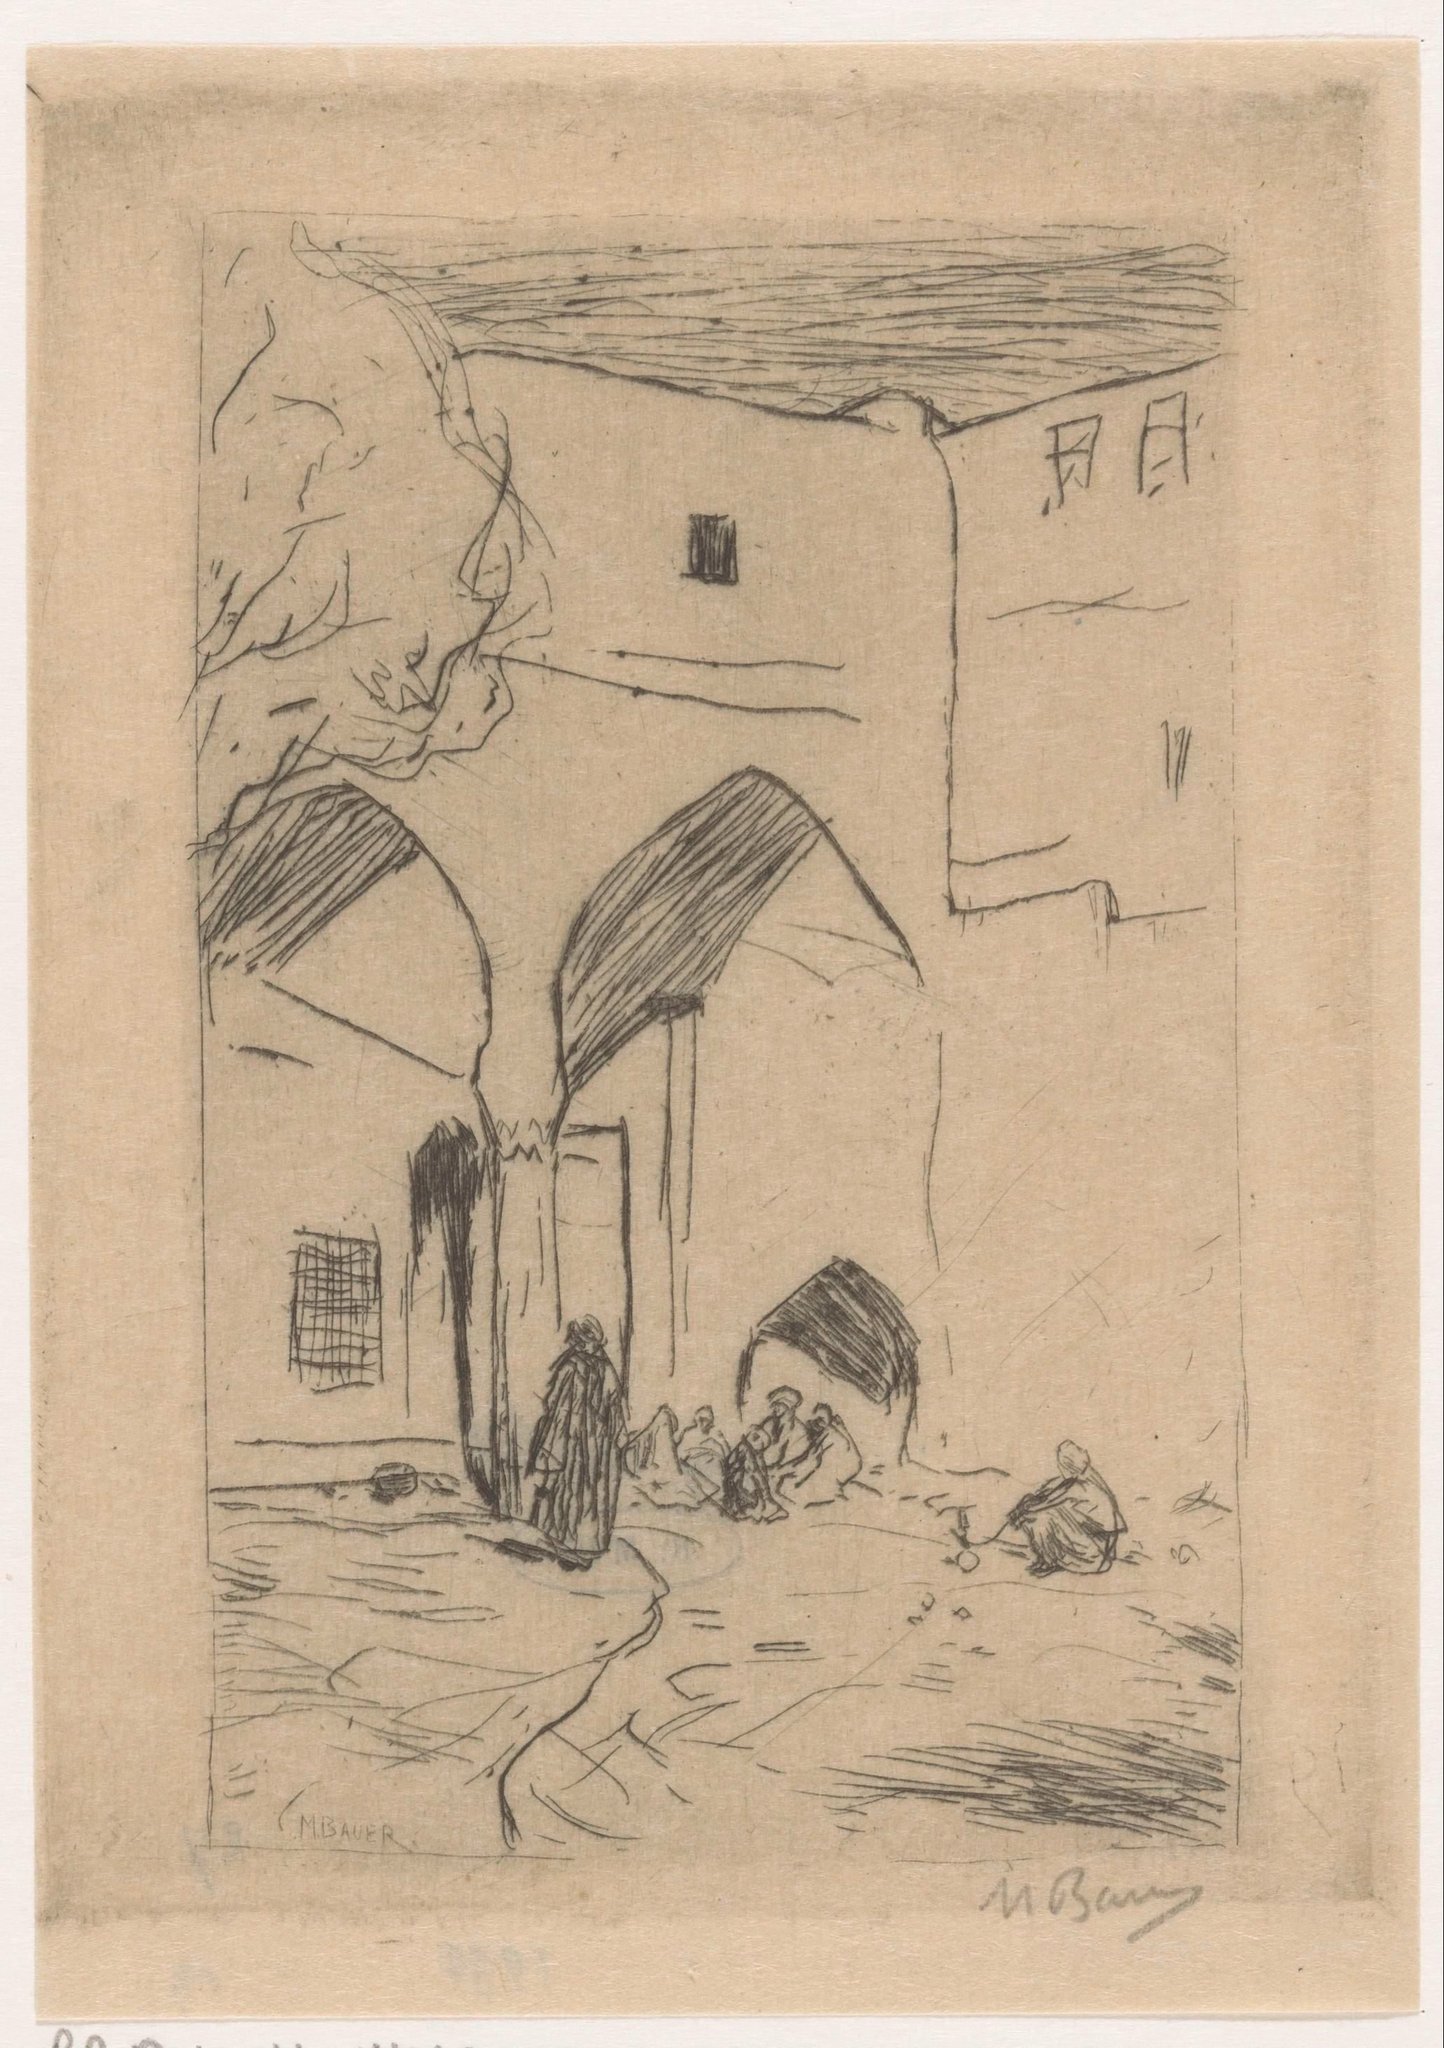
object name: print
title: Binnenplaats van een moskee in Scutari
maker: marius bauer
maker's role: draughtsman, print maker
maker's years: 1867-1932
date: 1889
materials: paper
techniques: etching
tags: temple, shrine ~ islam, mohammedanism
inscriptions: collector's mark: Lugt 2228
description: Binnenplaats van een moskee in Scutari, de Griekse naam voor het huidige Üsküdar in Turkije, met daarin enkele figuren.